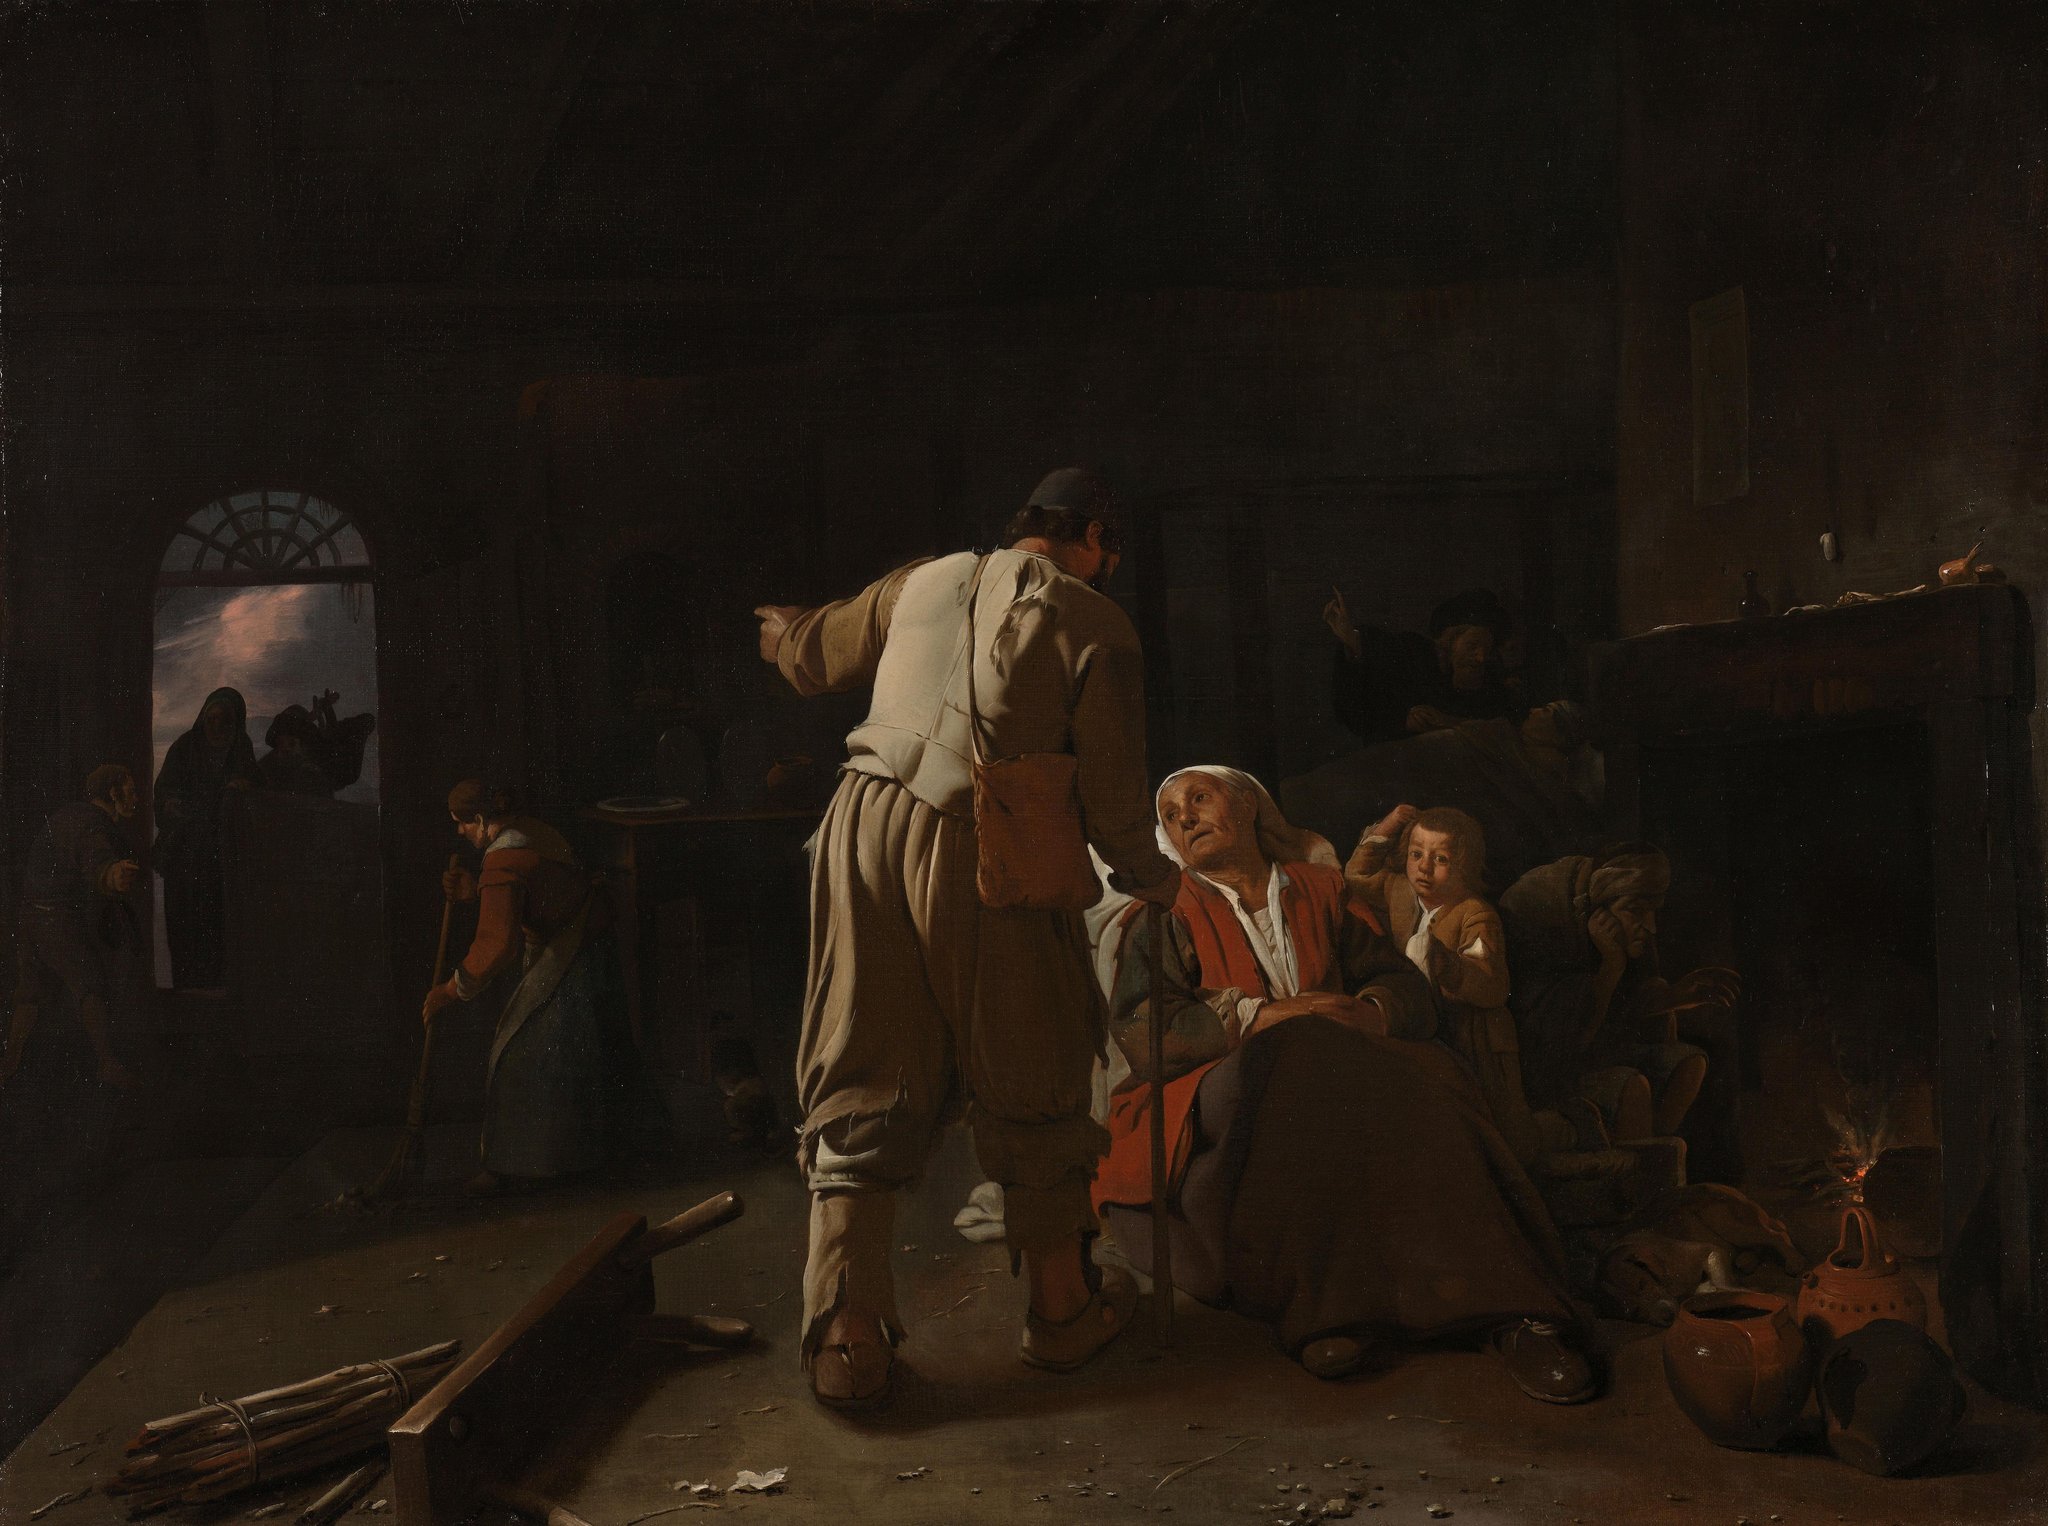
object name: painting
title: Visiting the Sick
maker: michael sweerts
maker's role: painter, print maker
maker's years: 1618-1664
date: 1646-1649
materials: canvas, oil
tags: visiting the sick, 'aeger curatur' ~ one of the (seven) acts of mercy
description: Helpful visitors enter the home of a poor family to minister to the sick. Seated next to a bed, a doctor points his finger upward, as though to say that only God holds man’s fate in his hands. Standing by the side of an old woman is a child, who gazes imploringly at the viewer.